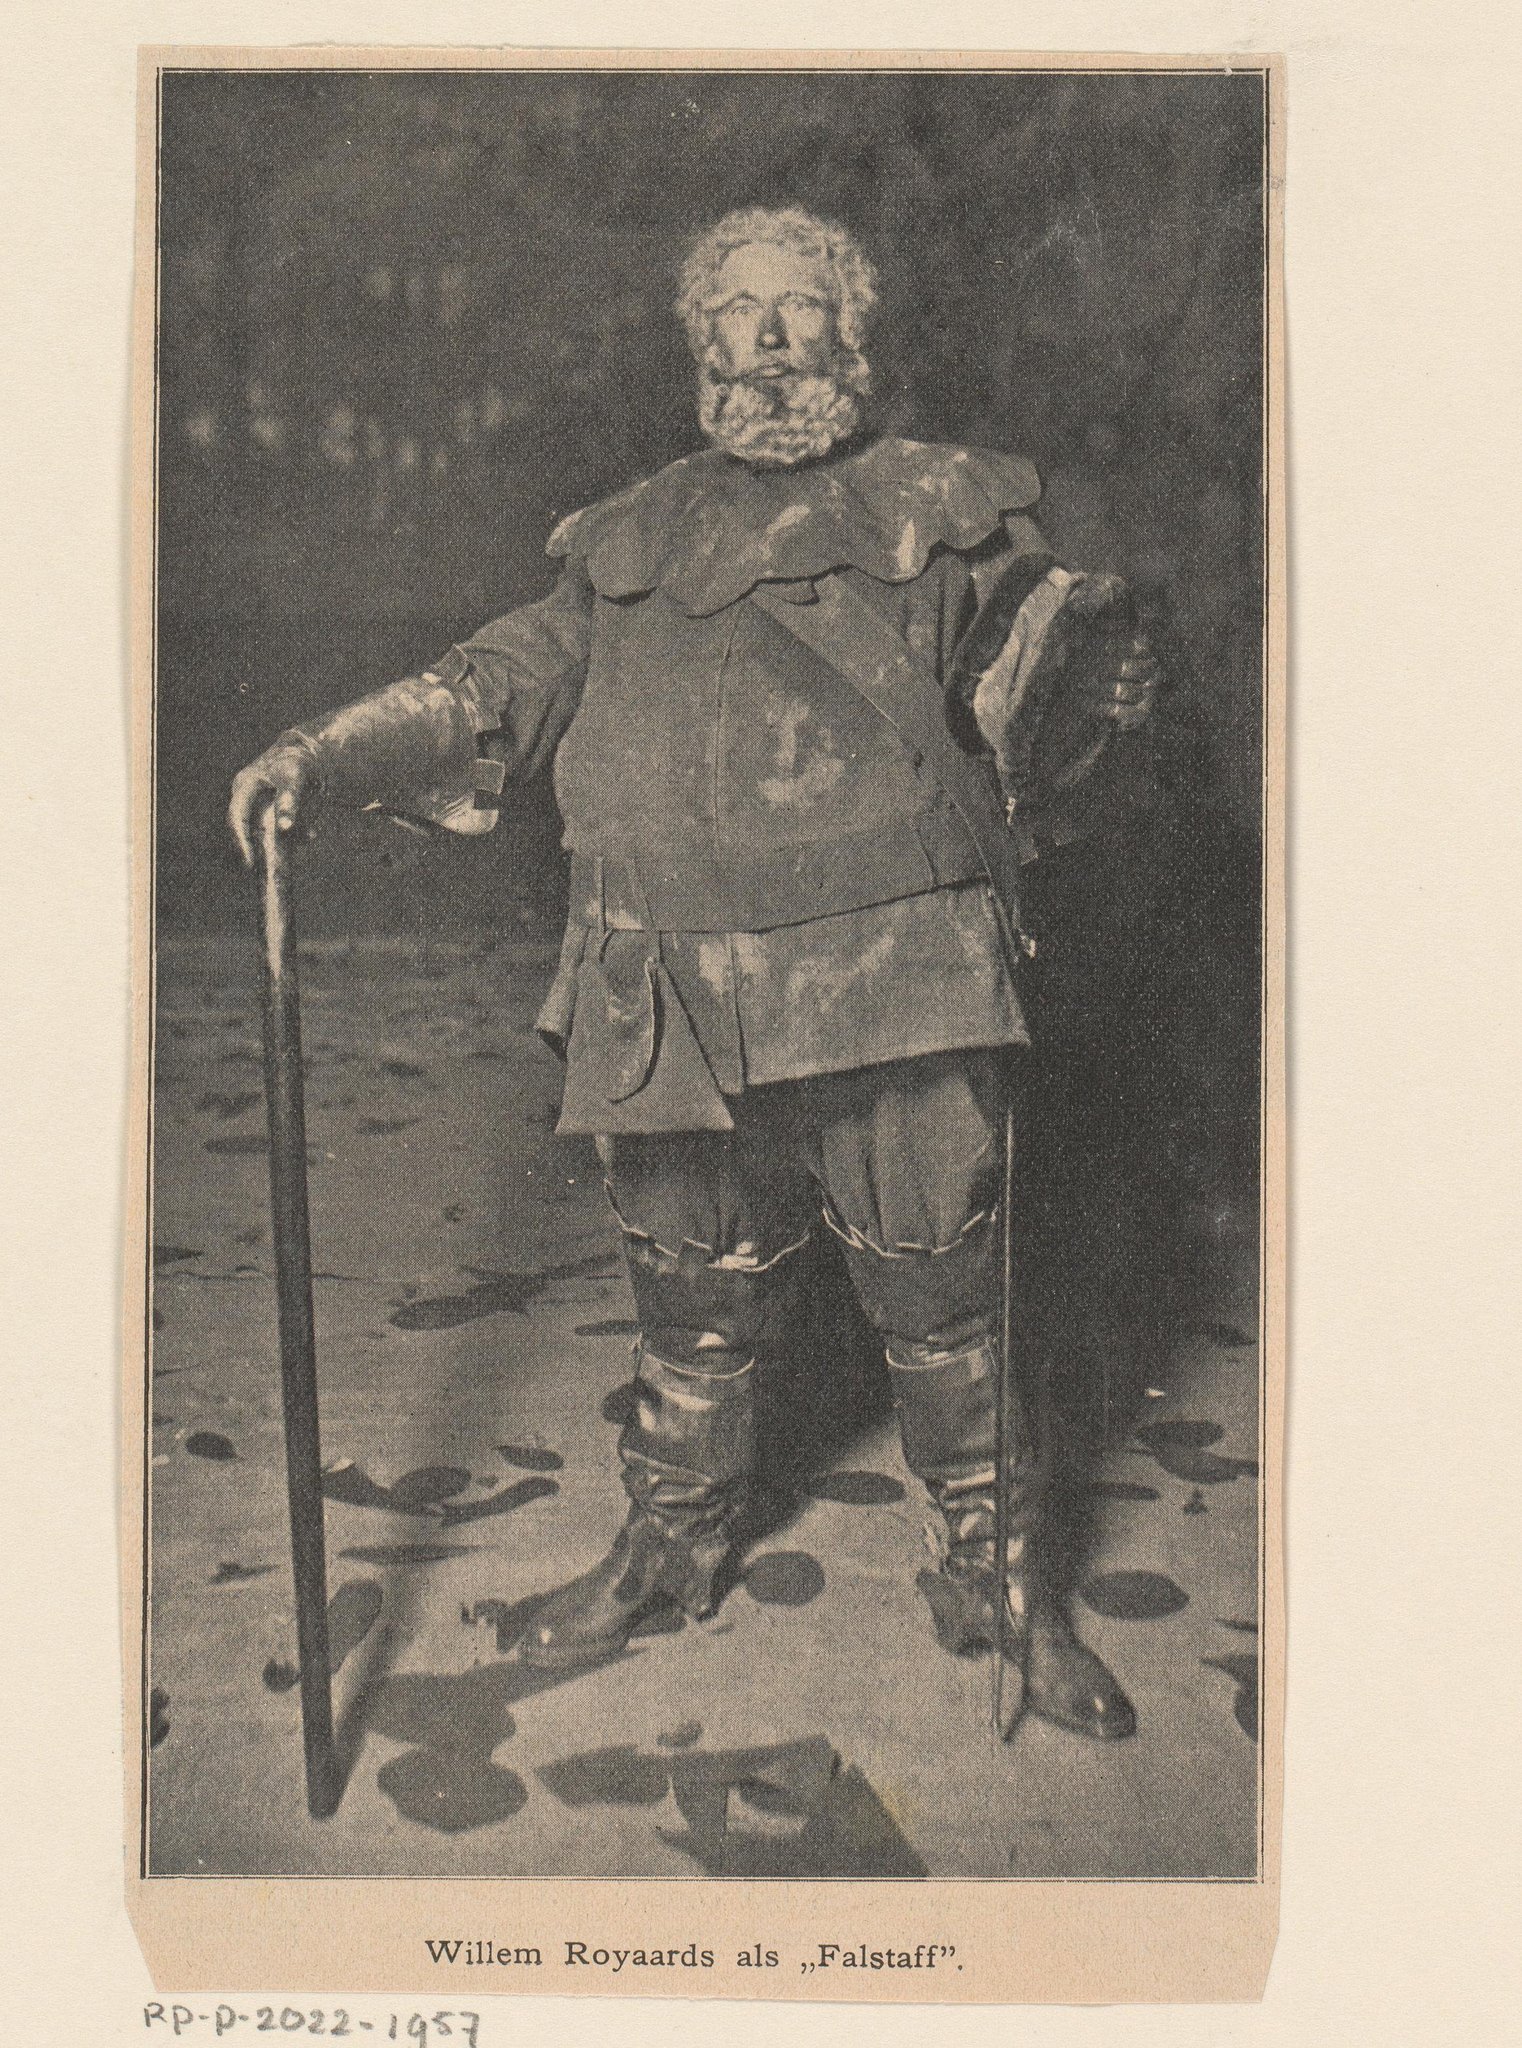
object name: photomechanical print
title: Portret van Willem Royaards als Falstaff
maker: Anonymous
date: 1909-1910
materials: paper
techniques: autotype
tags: willem cornelis royaards, historical persons, portrait of actor, actress